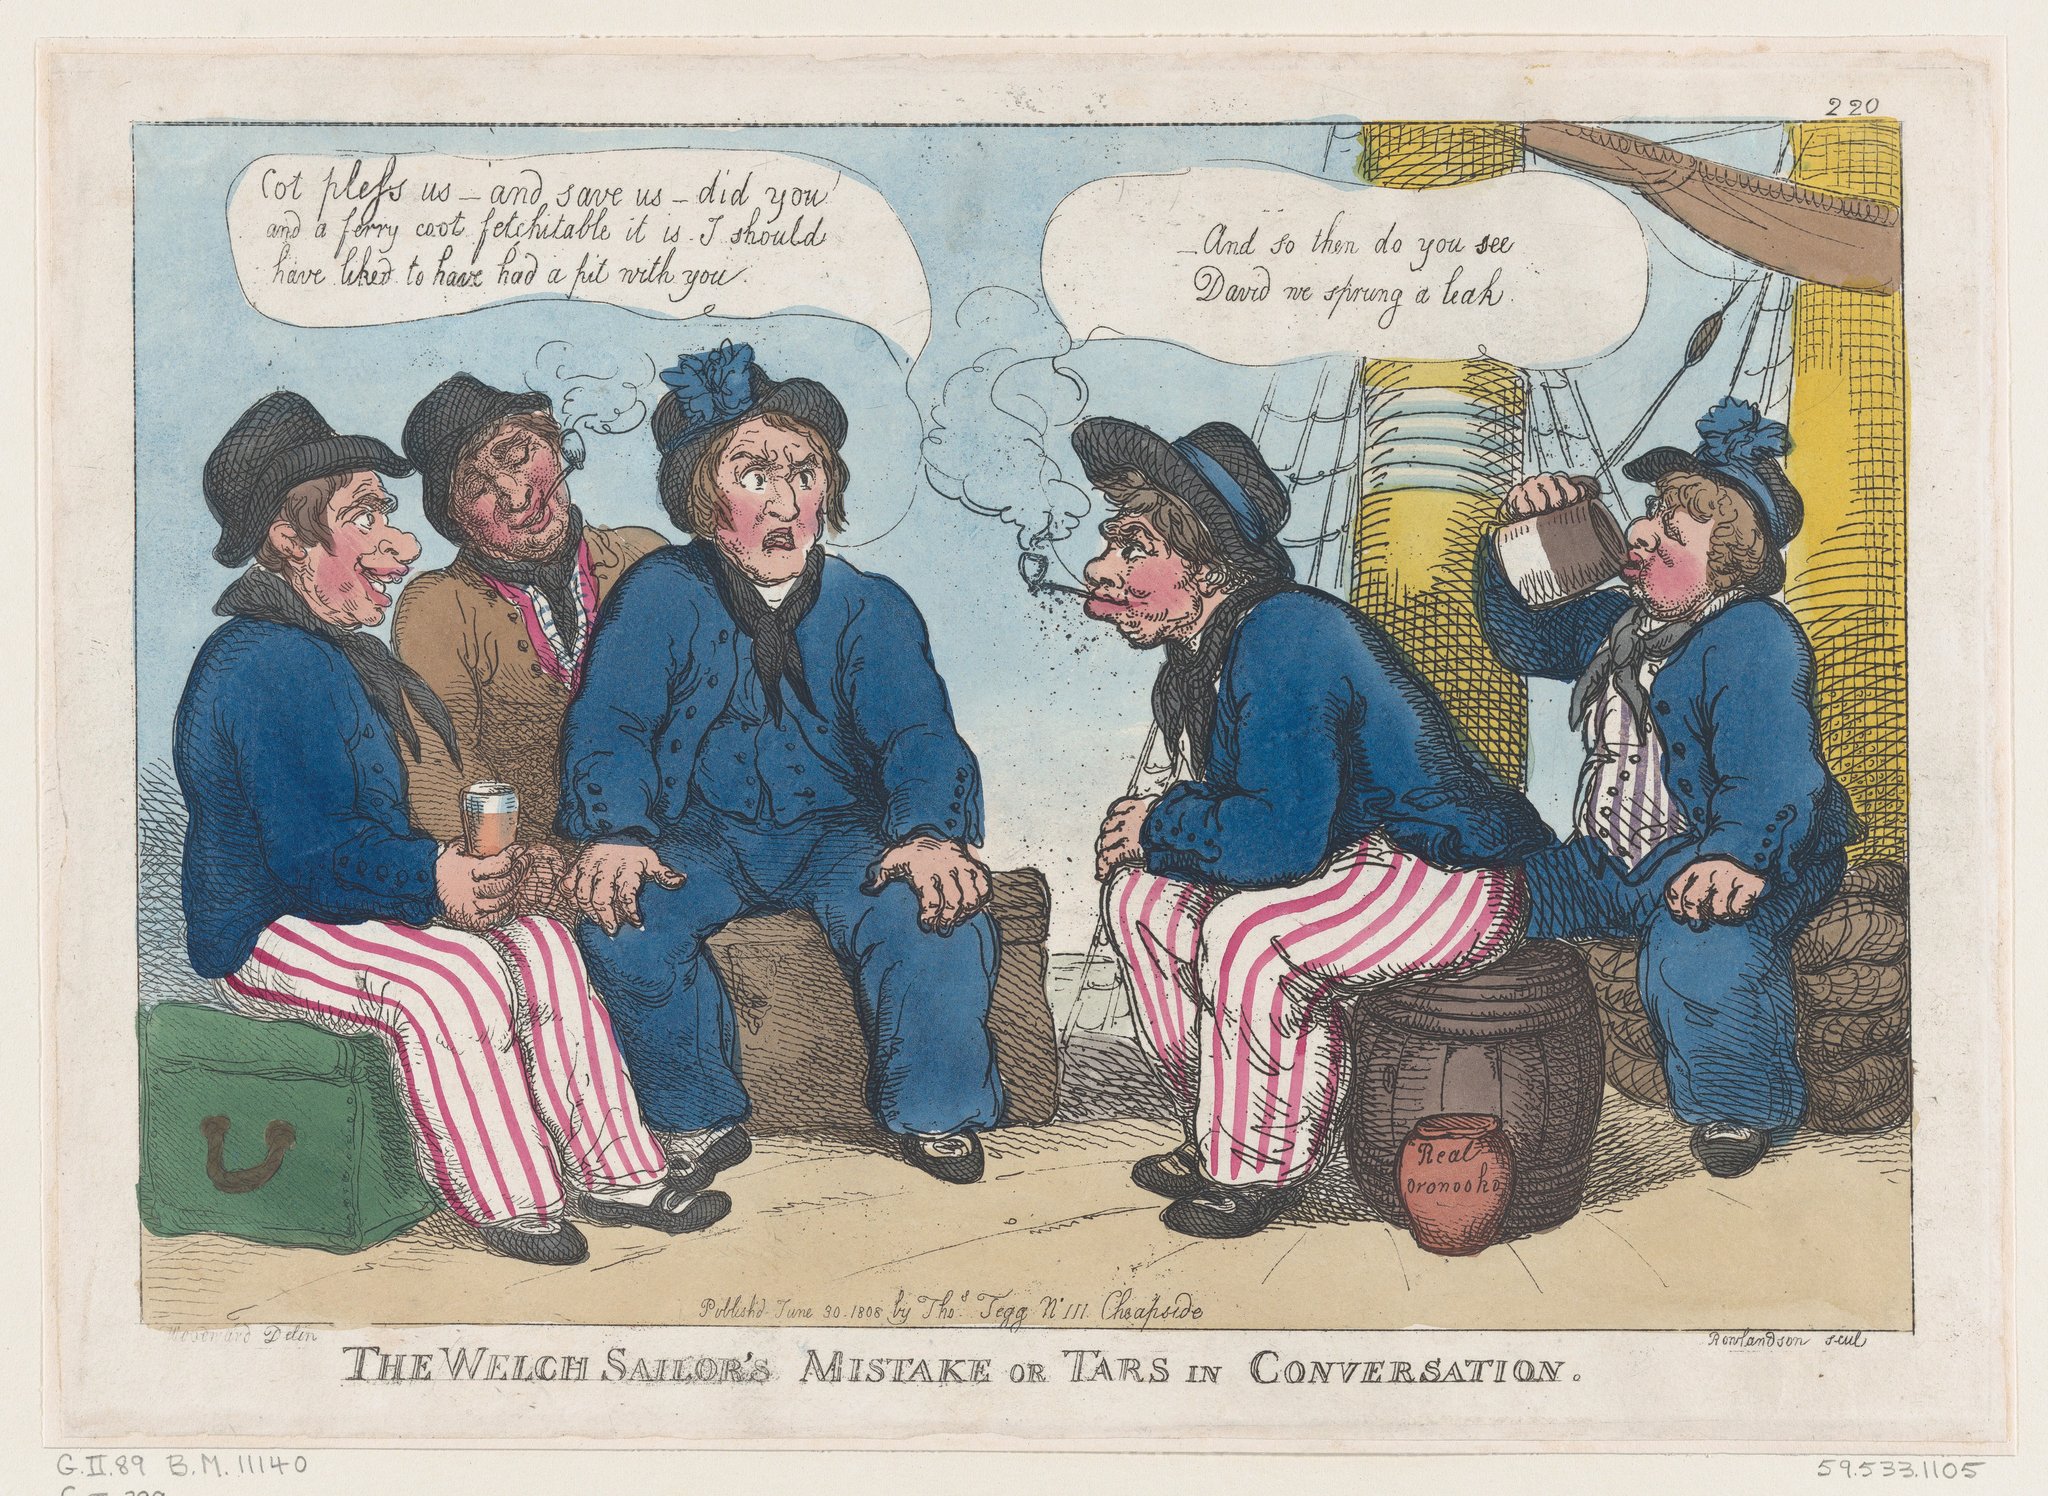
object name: print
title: The Welsh Sailor's Mistake, or Tars in Conversation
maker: thomas rowlandson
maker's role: artist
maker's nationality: british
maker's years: 1757-1827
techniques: etching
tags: satire,men,smoking,drinking